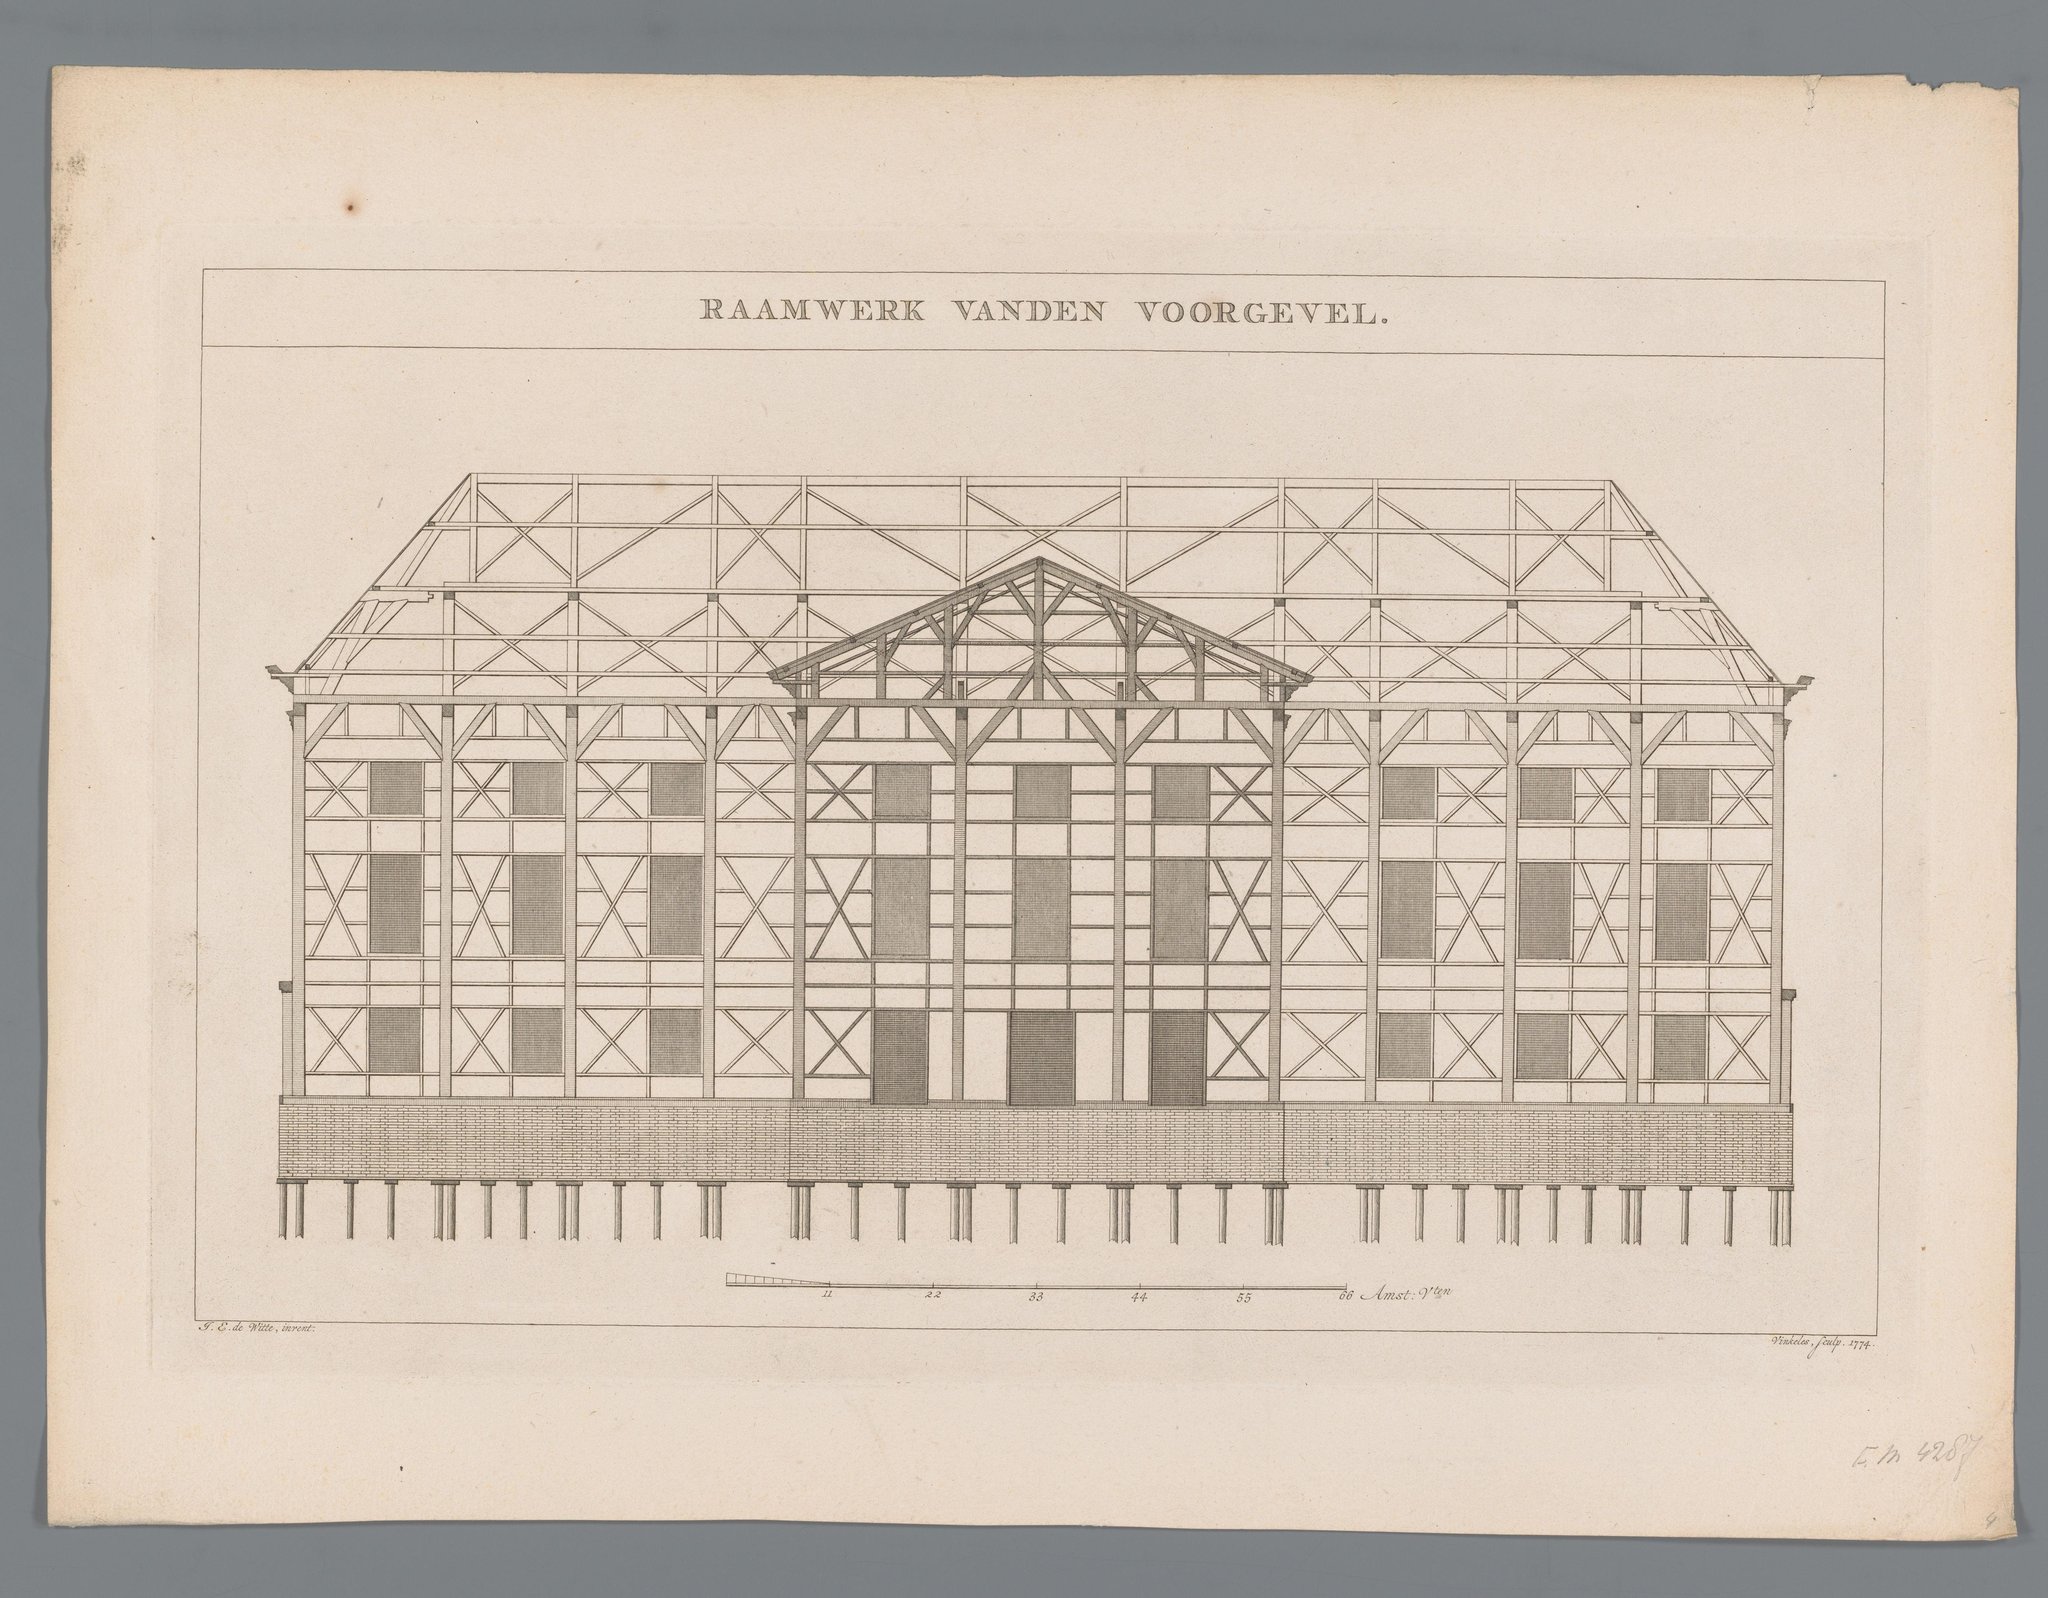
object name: print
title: Raamwerk vanden voorgevel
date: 1774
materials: paper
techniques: etching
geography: amsterdam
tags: theatre (building), amsterdam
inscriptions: date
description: Prent uit: Witte, Jacob Eduard de. Afbeeldingen van den schouwburg te Amsterdam. Amsterdam: Johannes Smit, 1774.